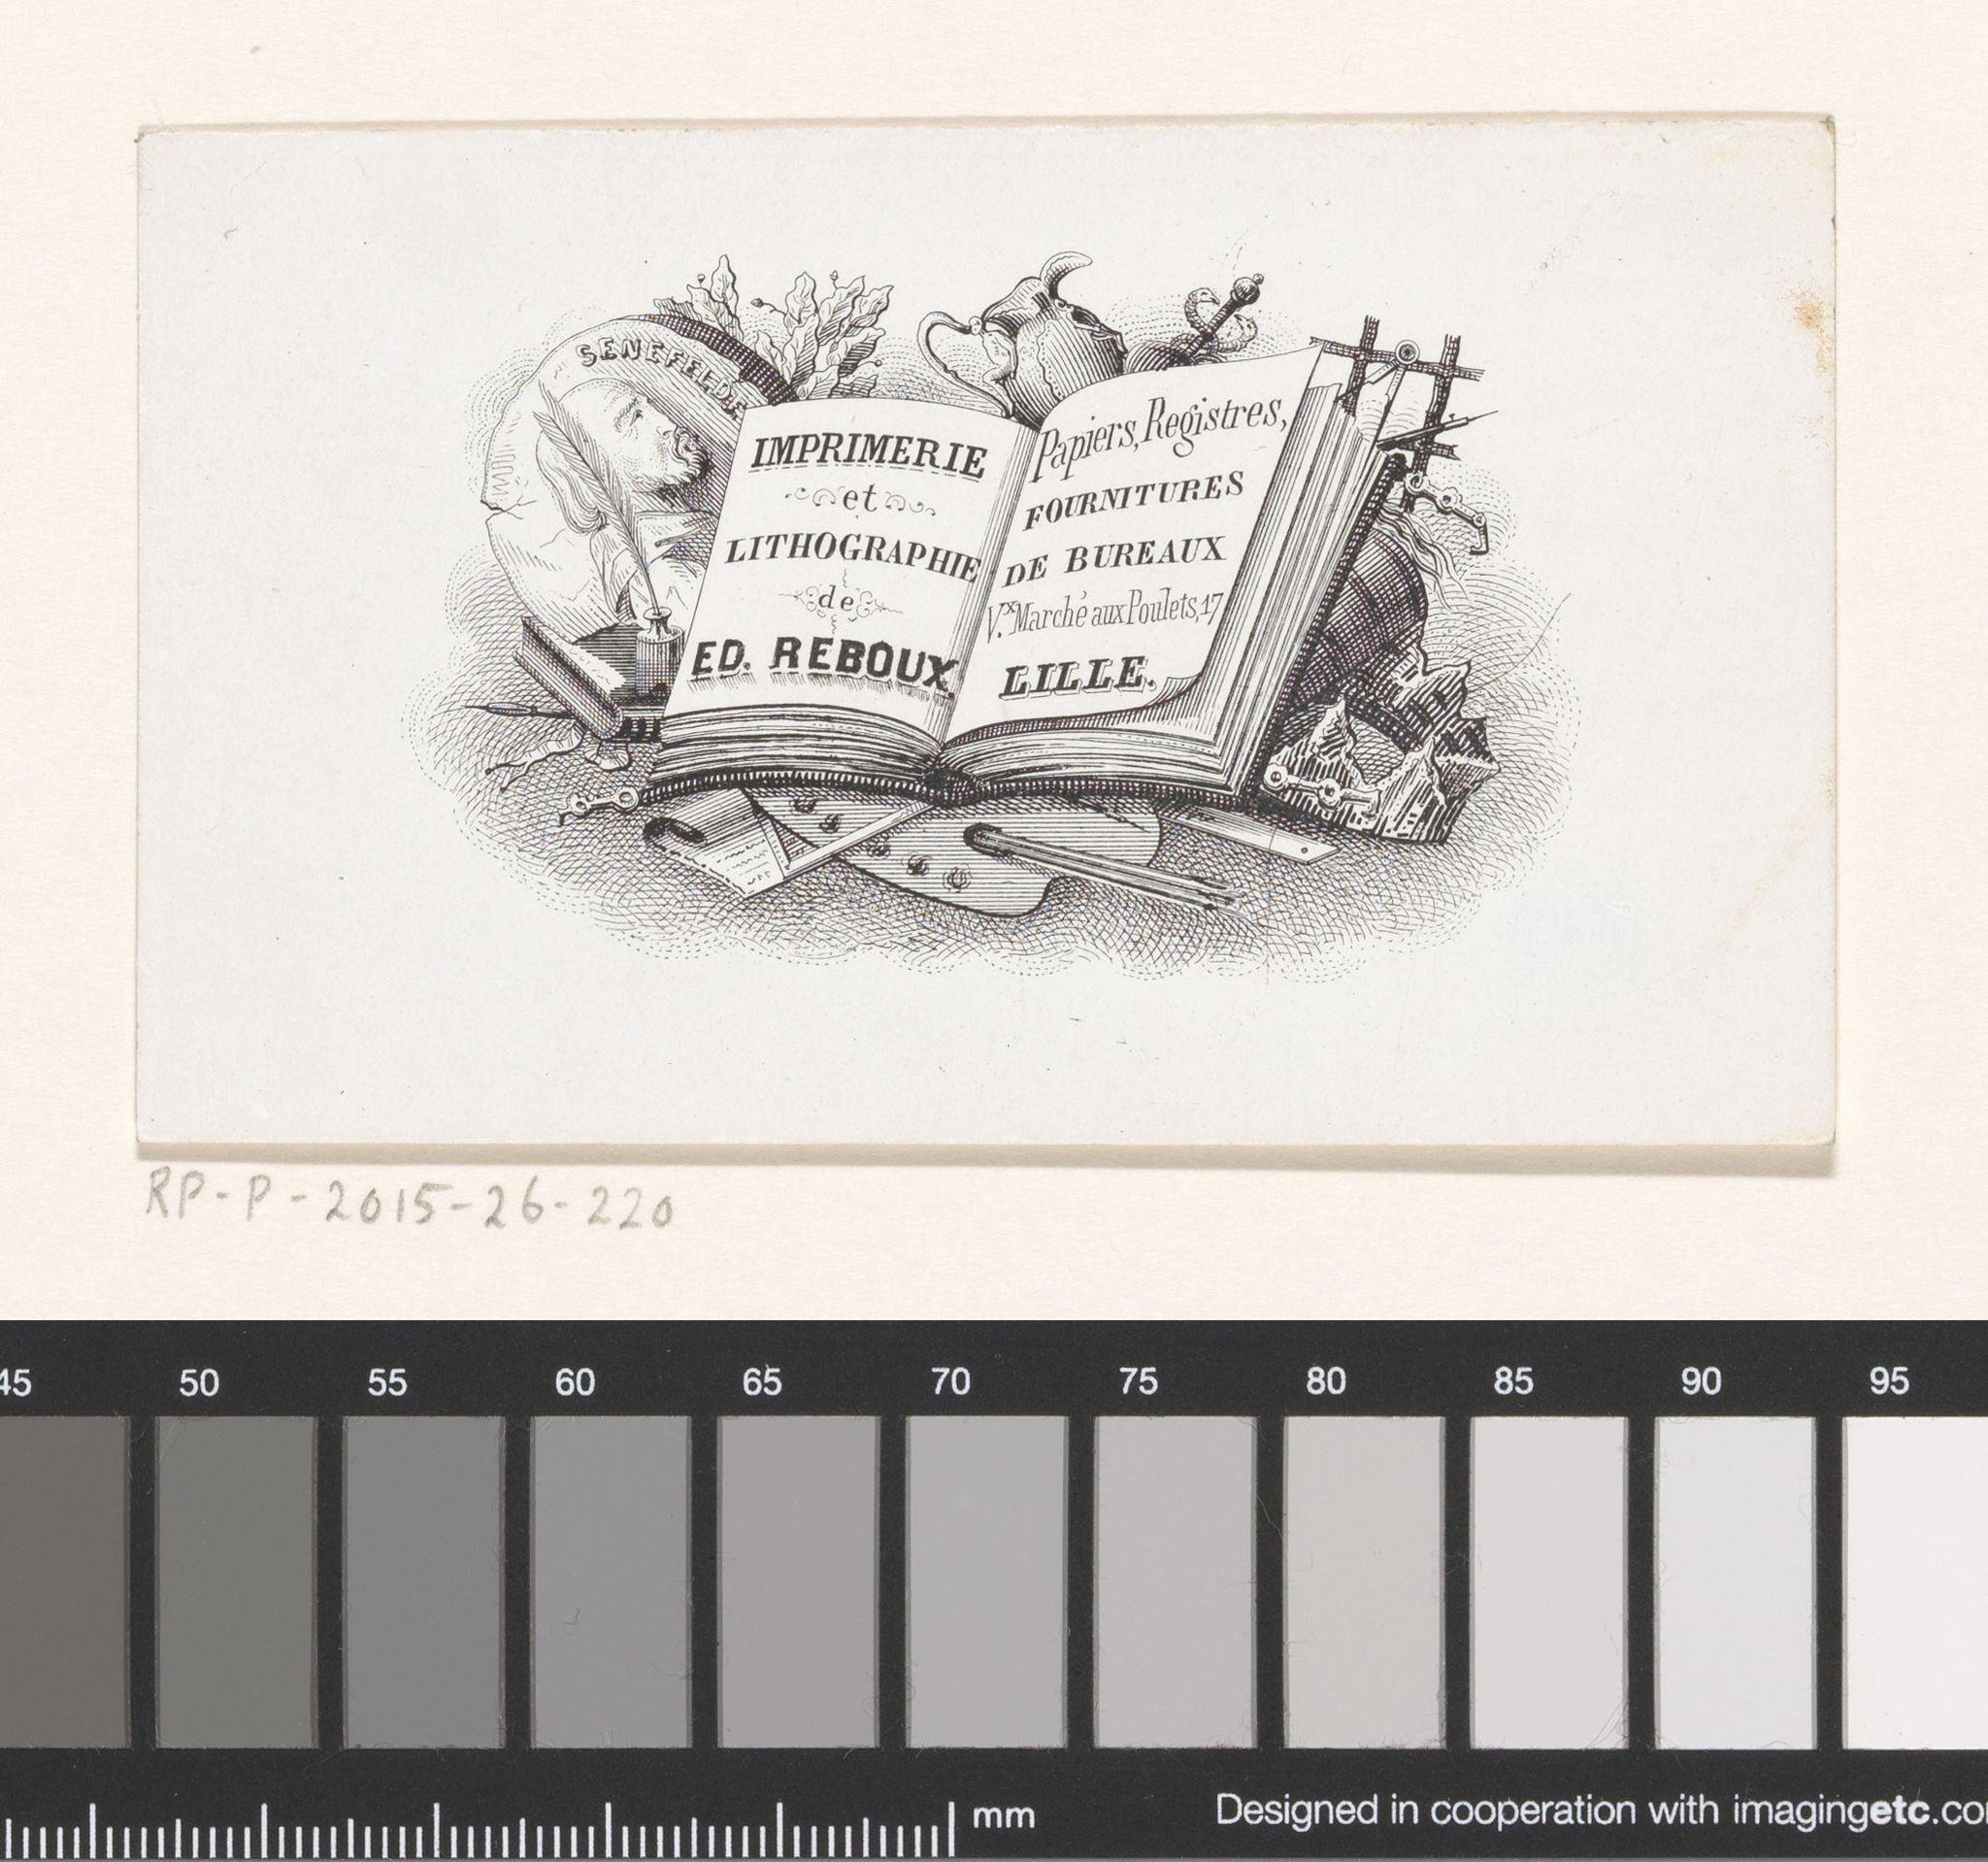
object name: visiting card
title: Visitekaartje van drukkerij Éduard Reboux te Lille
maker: édouard-henri-joseph reboux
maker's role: print maker, printer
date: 1850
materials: porcelainized cardboard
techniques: lithograph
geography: lille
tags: prague, print maker, printer, alois senefelder, quill, tools, implements of graphic artist, still life of related objects, book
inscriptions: collector's mark: Lugt 2228, collector's mark: Lugt 4780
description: Een opengeslagen boek omringd door verschillende objecten waaronder een portret van Alois Senefelder, een passer, een schilderspalet en een inktpot met ganzenveer.